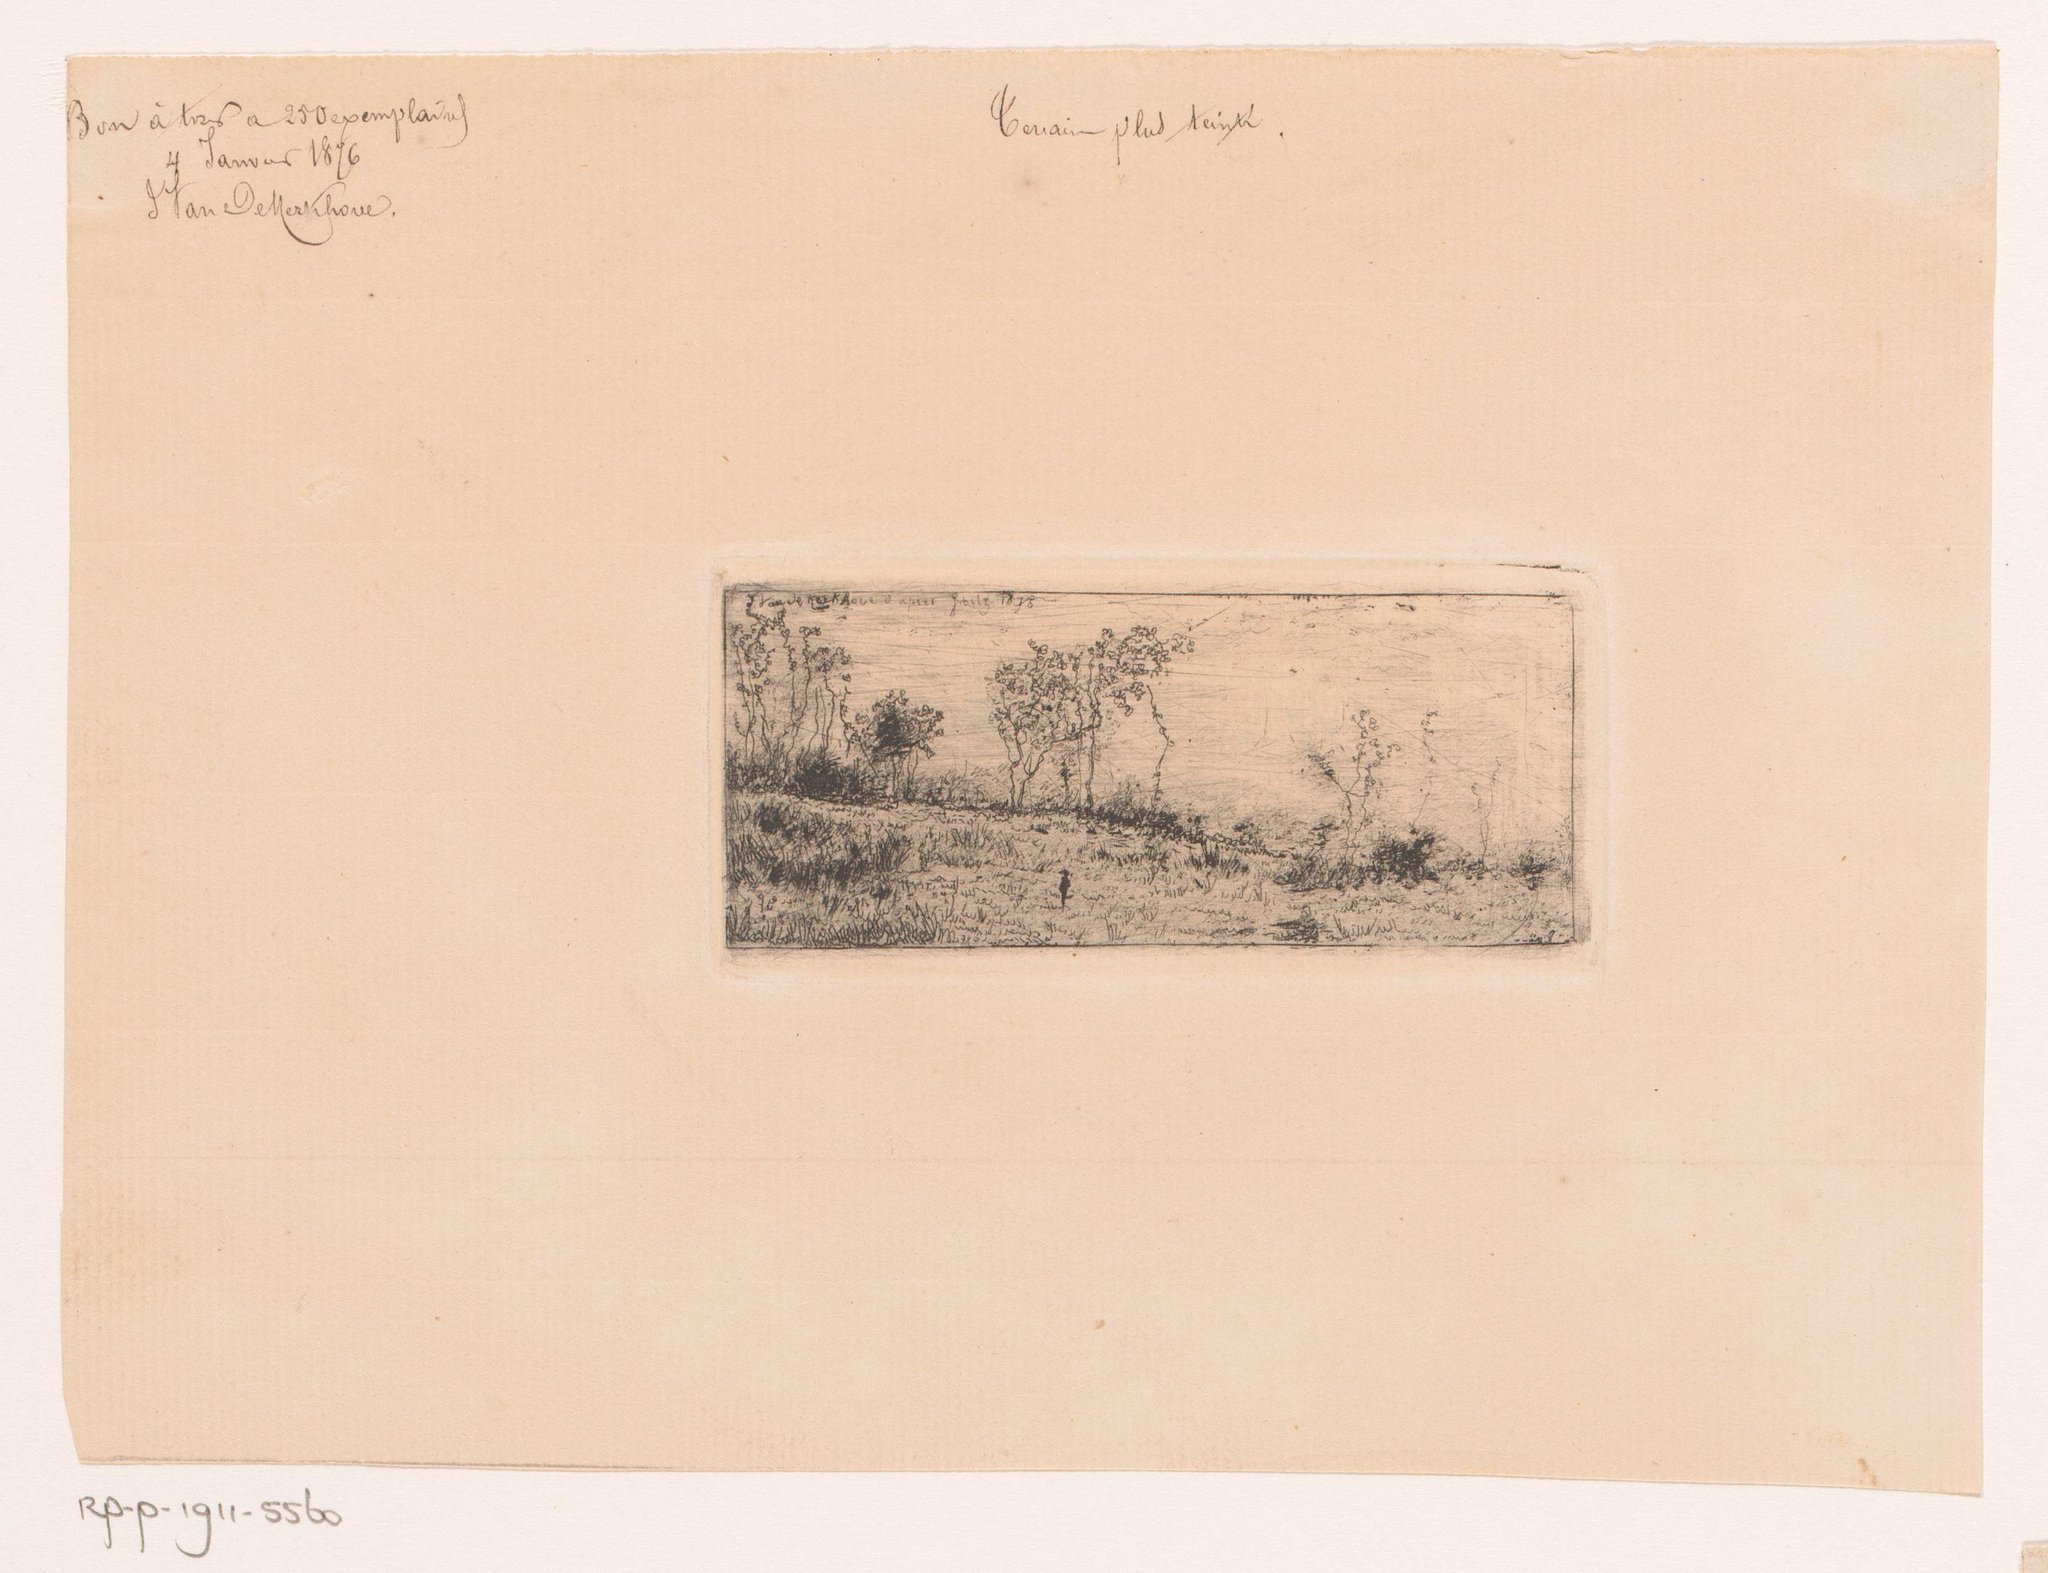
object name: print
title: Landschap met bomen en klein figuur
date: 1875-1876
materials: paper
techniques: etching, intaglio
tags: landscapes in the temperate zone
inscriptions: annotation: ‘Bon à tirer a 250 exemplaires 4 Janvier 1876’, collector's mark: Lugt 2228, annotation: ‘Terrain plus teint’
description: De etsen naar de schilderijen van Frédéric Van de Kerkhove werden na zijn dood door zijn vader en zuster gemaakt en uitgegeven in twee reeksen. De eerste werd in 1877 uitgegeven door het Journal des Beaux-Arts et de la Littérature: Cahier de 25 Eaux-fortes d'après Frédéric van de Kerkhove, gravées par son père et sa sœur. De tweede reeks van 126 etsen werd, ook in 1877, in Parijs uitgegeven bij A. Lévy onder de titel Cent eaux-fortes gravées par J. Van de Kerkhove d'après les tableaux de Frédéric Van de Kerkhove, mort en 1873 à l'âge de 10 ans et 11 mois.